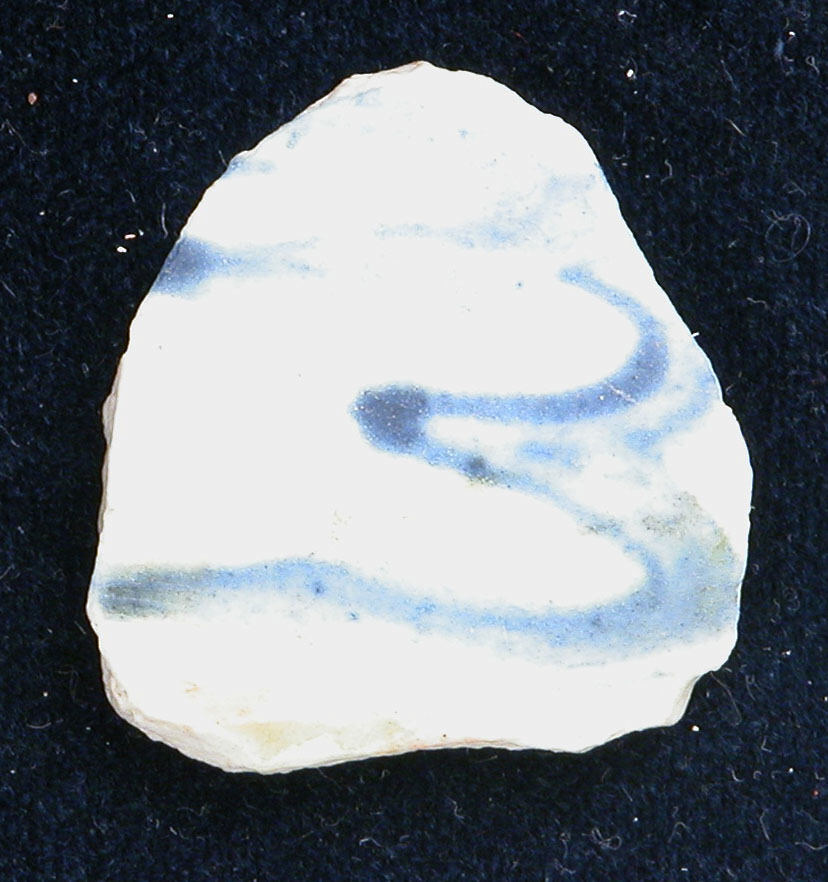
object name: fragment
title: Ceramic Fragment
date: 1201-1400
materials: porcelain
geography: saudi arabia